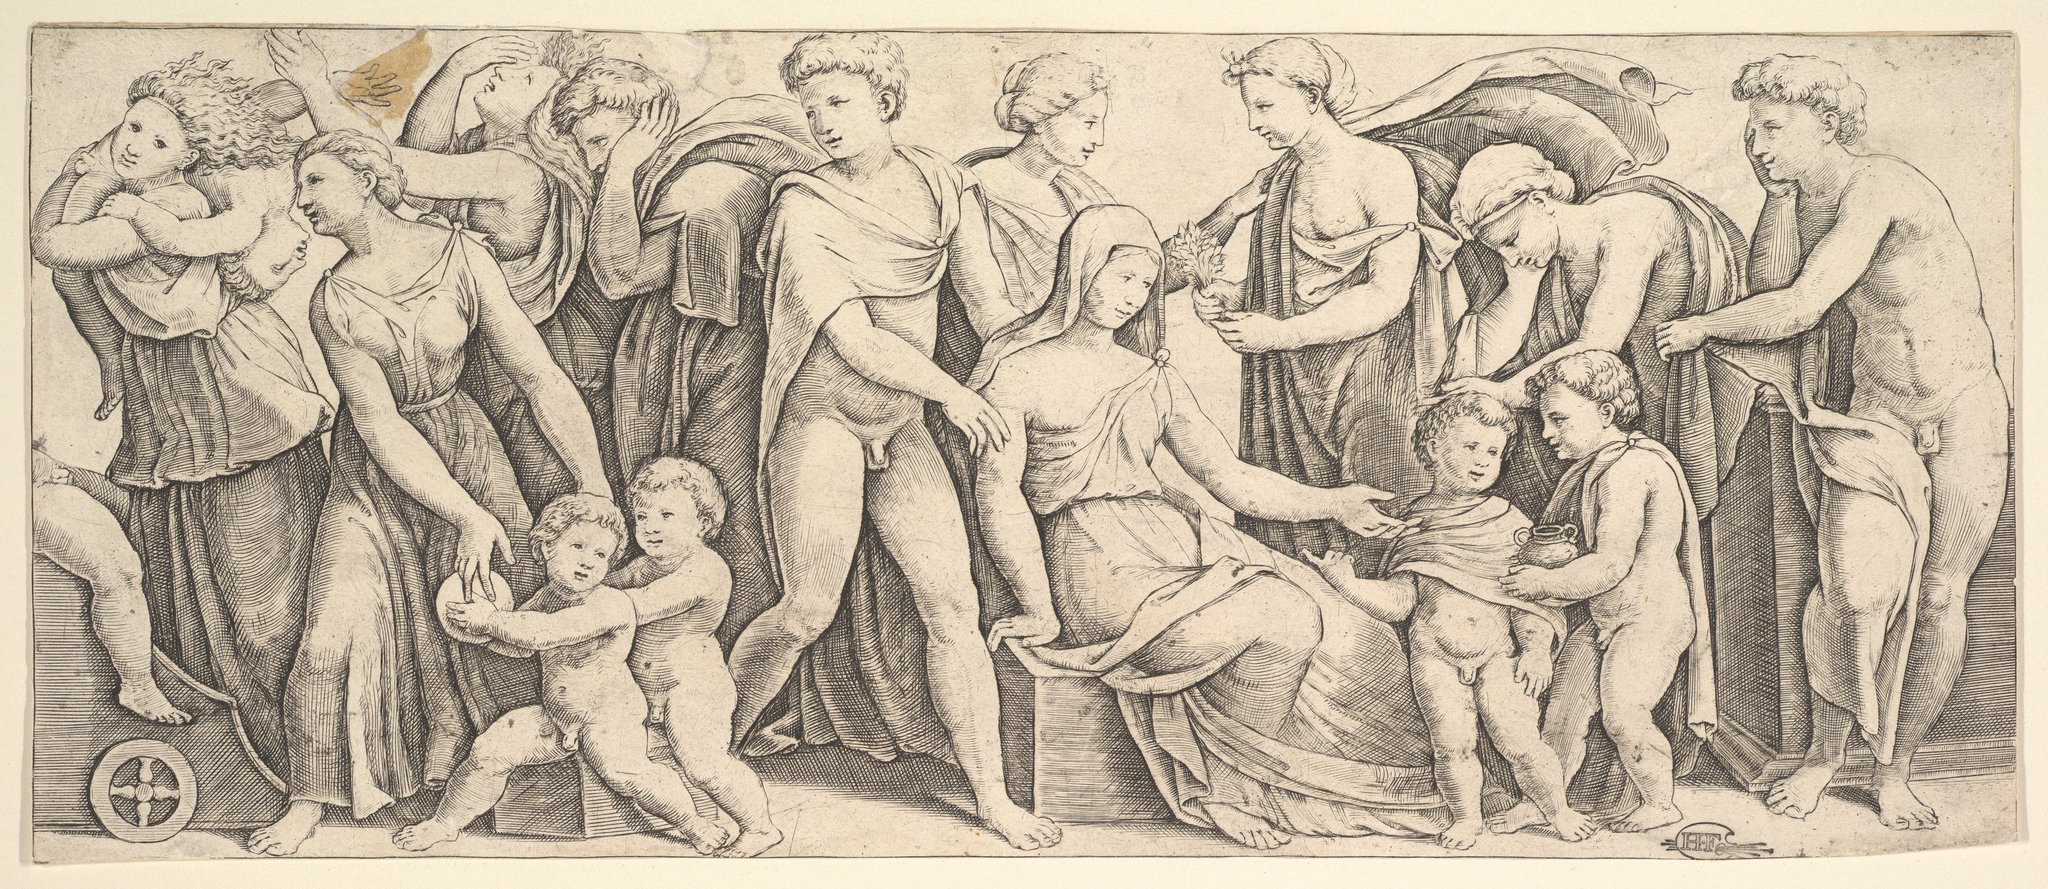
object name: print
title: The wedding of Jason and Creusa, at left Medea takes her children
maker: master of the die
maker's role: artist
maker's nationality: italian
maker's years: 1525-1560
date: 1530-1560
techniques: engraving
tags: boys,jason,medea